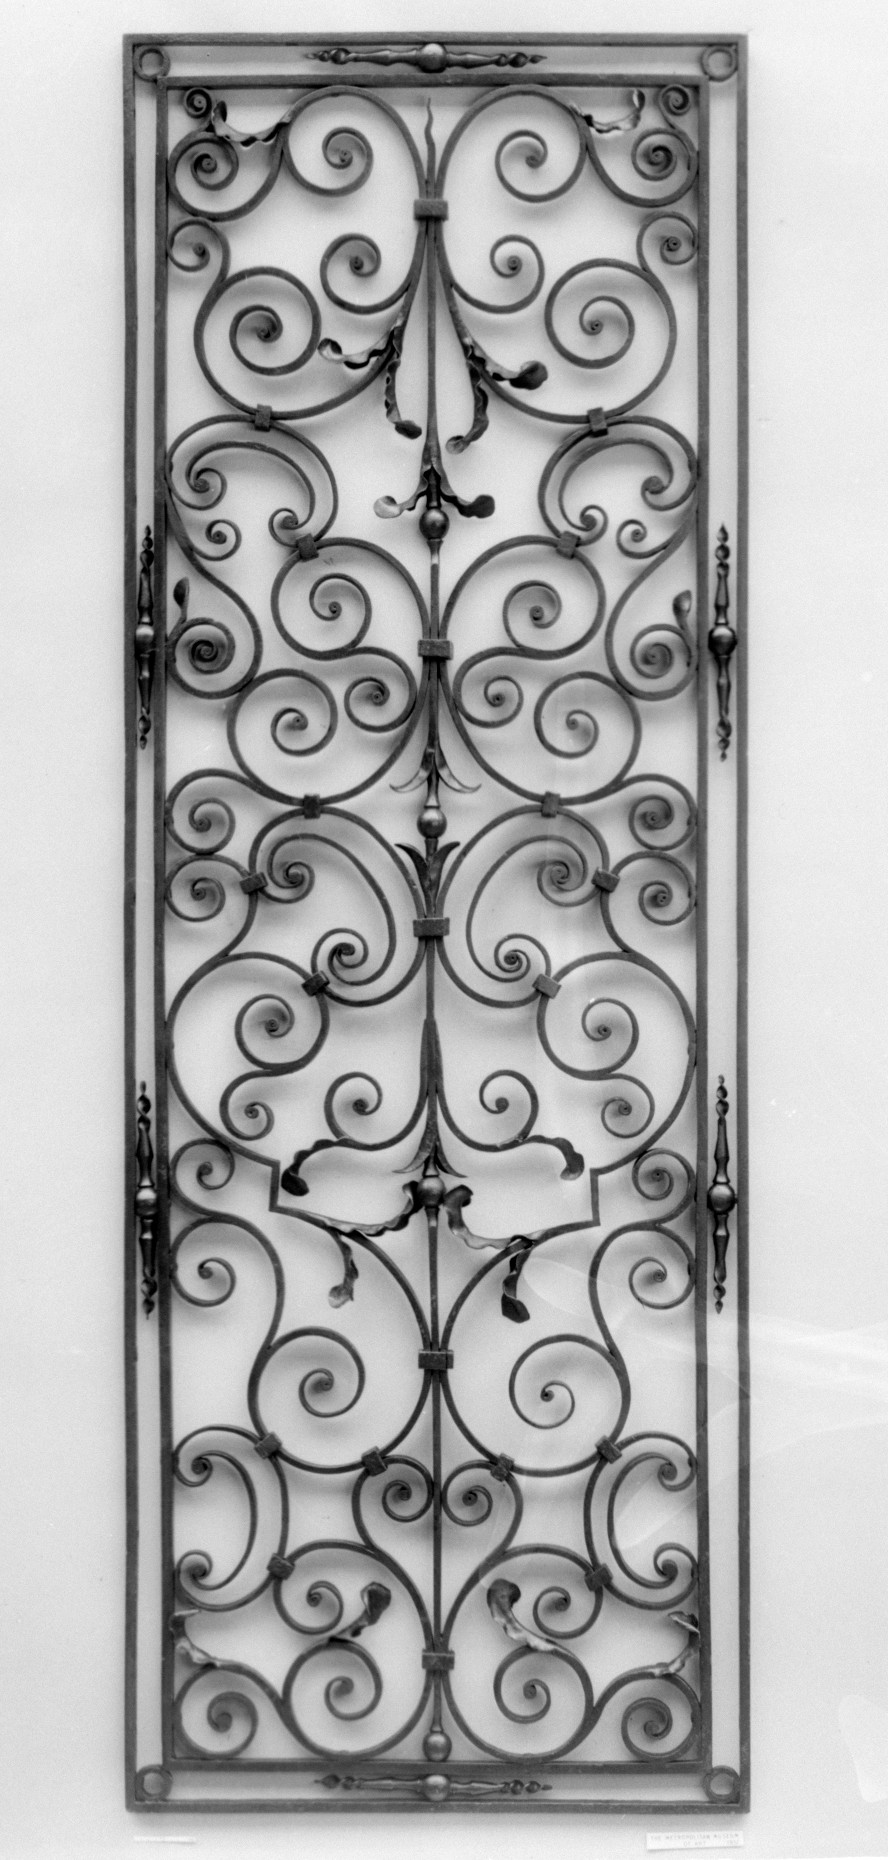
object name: panel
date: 1715-1730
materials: iron